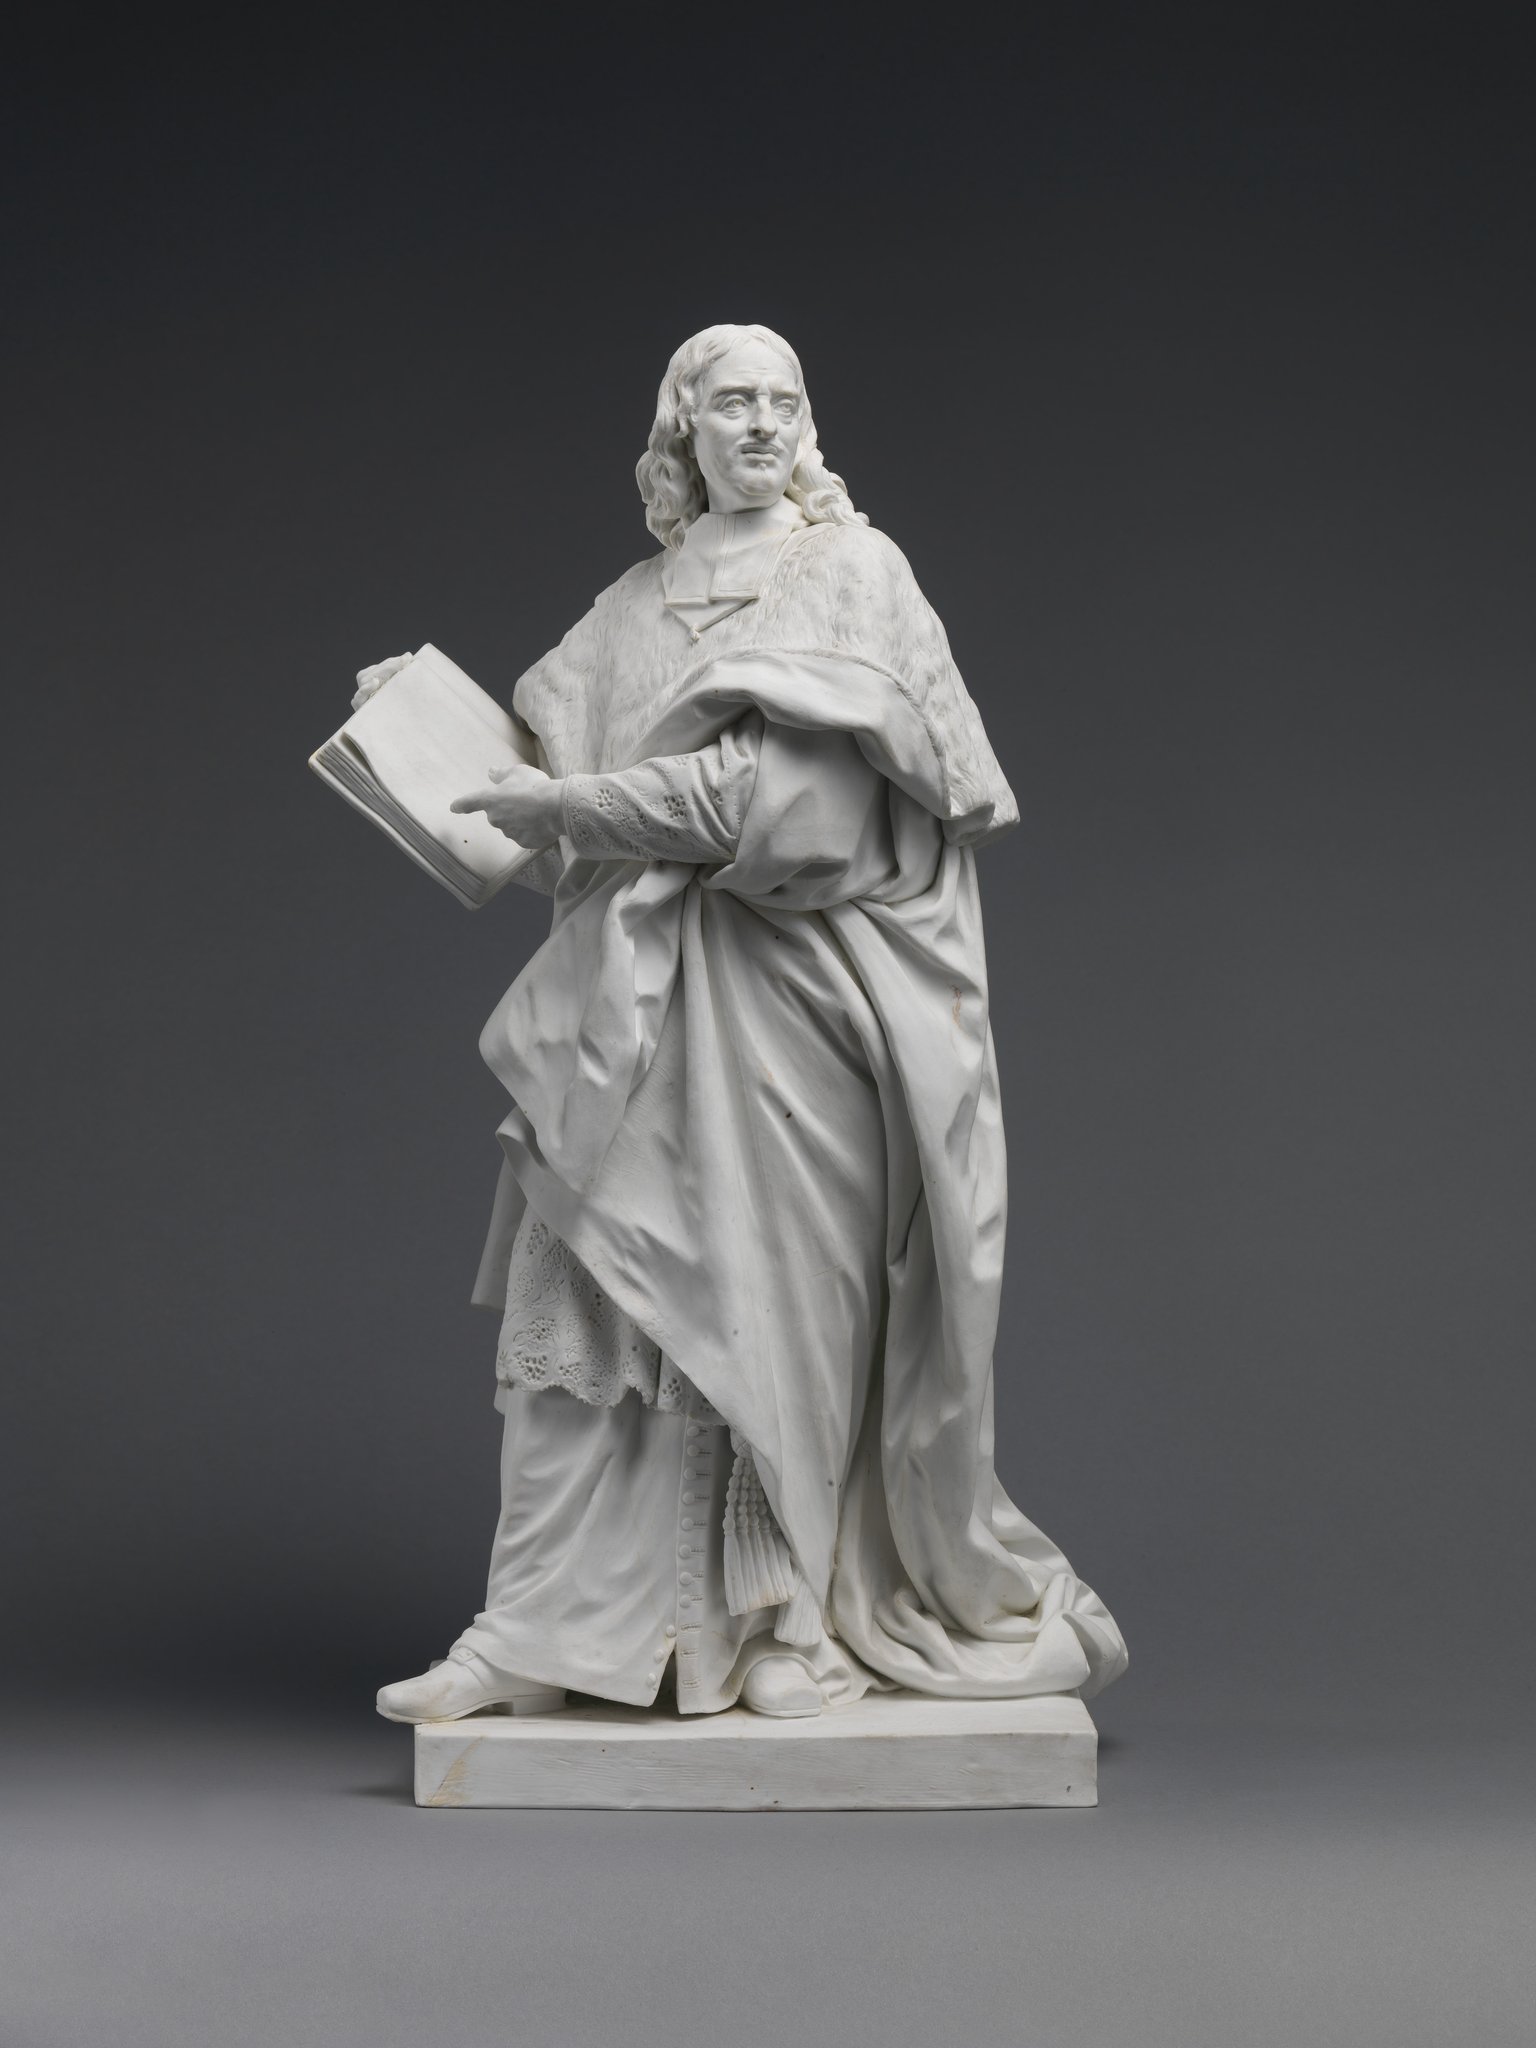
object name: statuette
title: Jacques-Bénigne Bossuet (1627–1704)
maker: sèvres manufactory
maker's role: manufactory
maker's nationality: french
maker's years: 1740-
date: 1784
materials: biscuit, paste, porcelain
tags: books,bishops